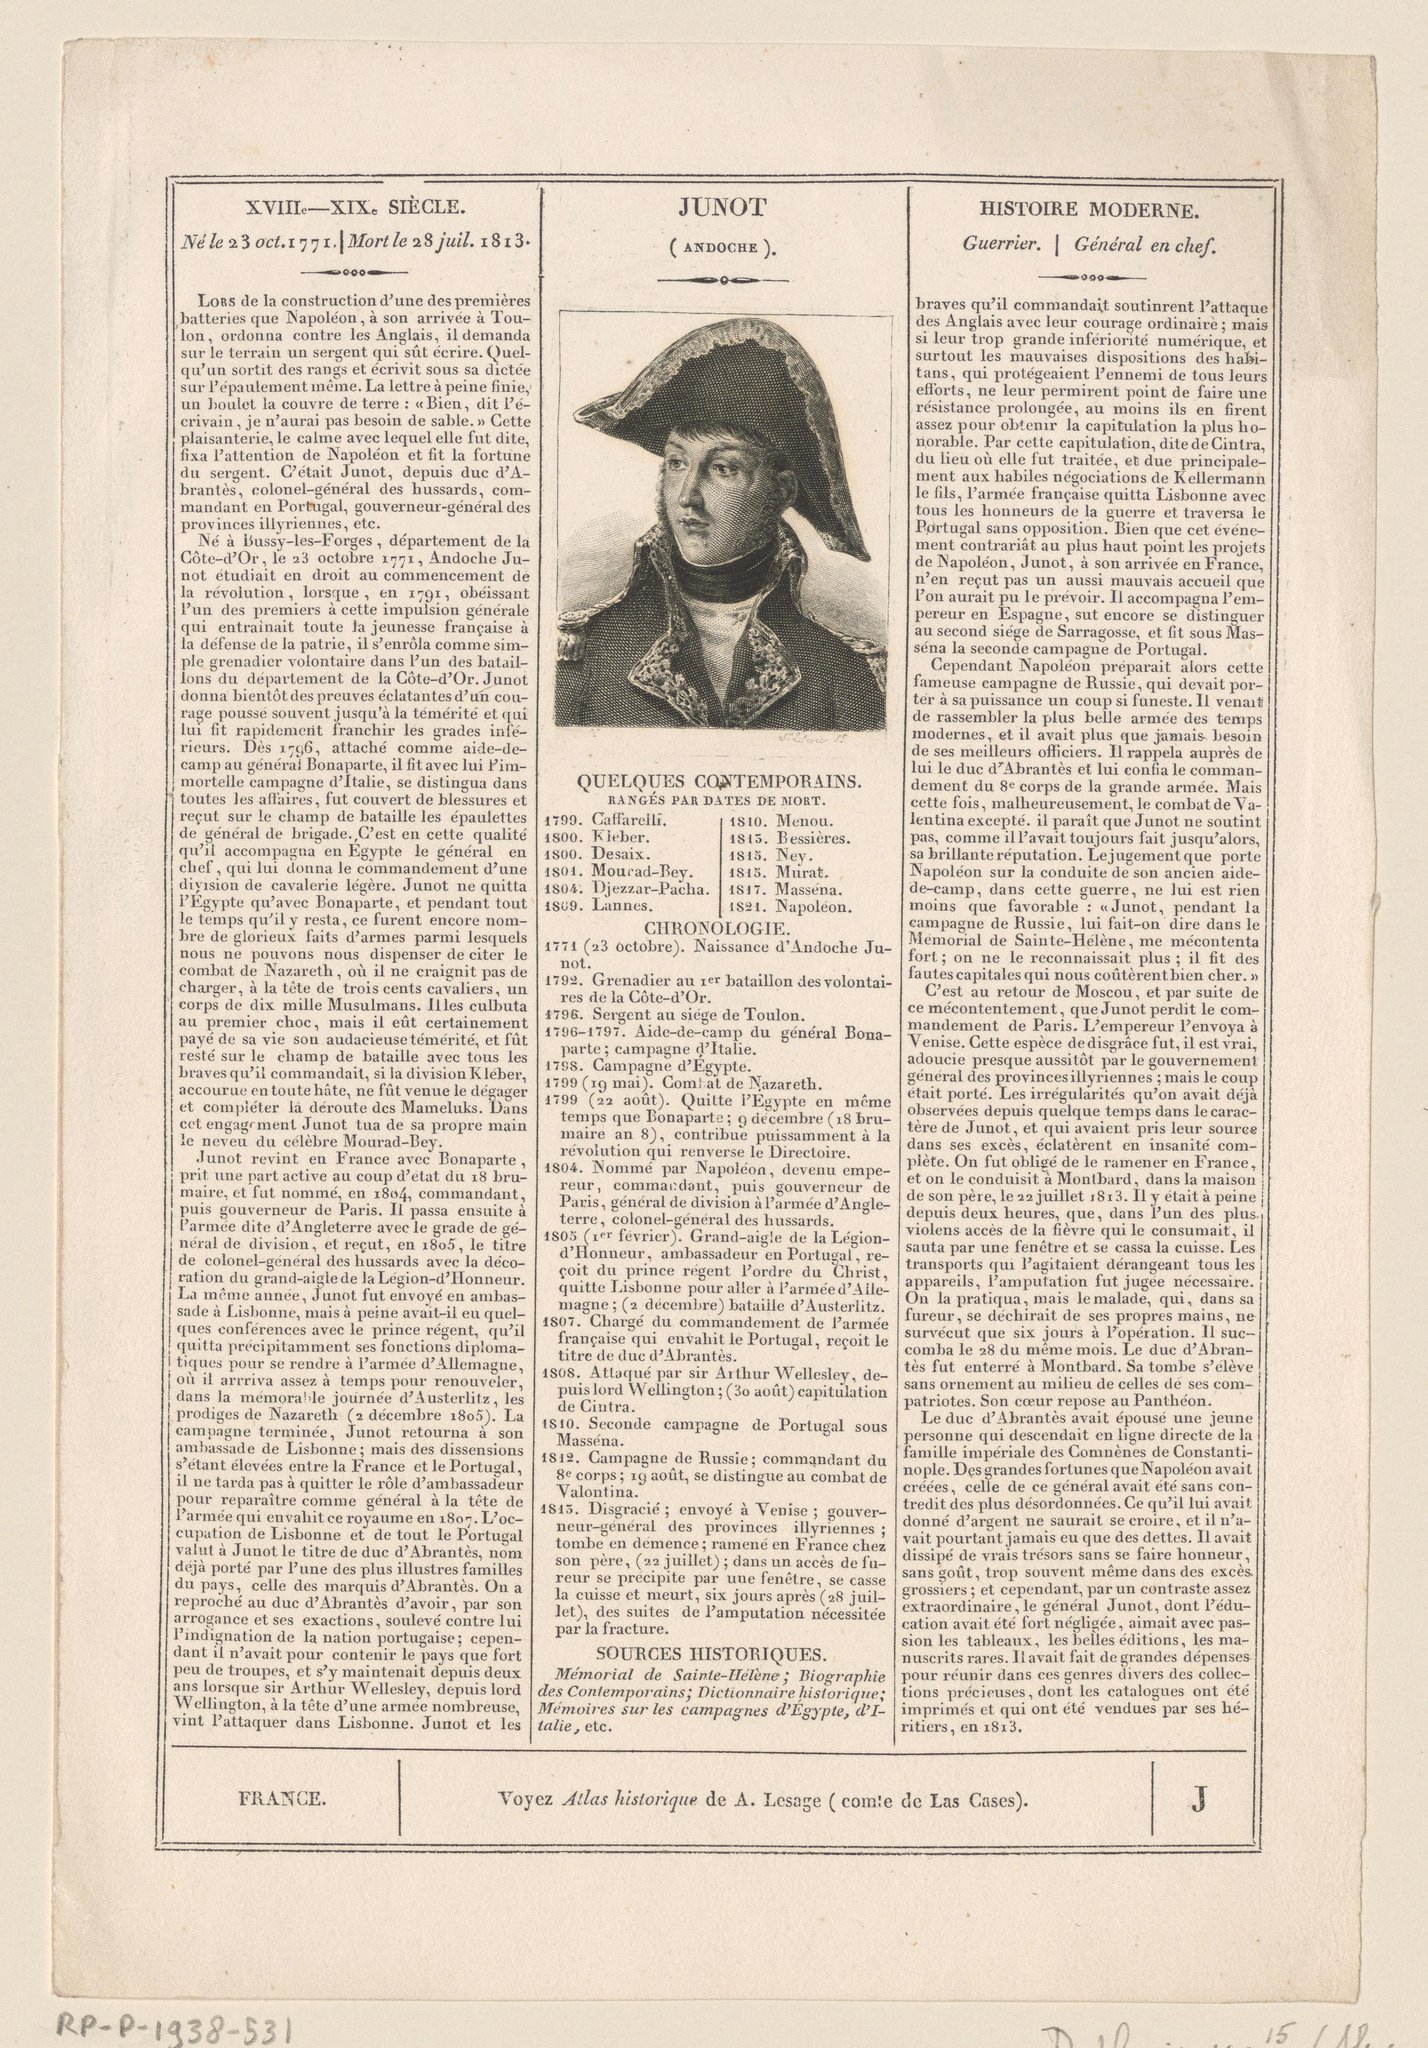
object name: print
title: Galerie historique, collection de 200 portraits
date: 1839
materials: paper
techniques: engraving, etching, letterpress printing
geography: paris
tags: commander-in-chief, general, marshal, historical persons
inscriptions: collector's mark: Lugt 2228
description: Prent uit: Fliniaux, Adolphe. Galerie historique. Collection de 200 portraits des personnages les plus célèbres de l'histoire moderne (...). Parijs: Bénard, 1839.